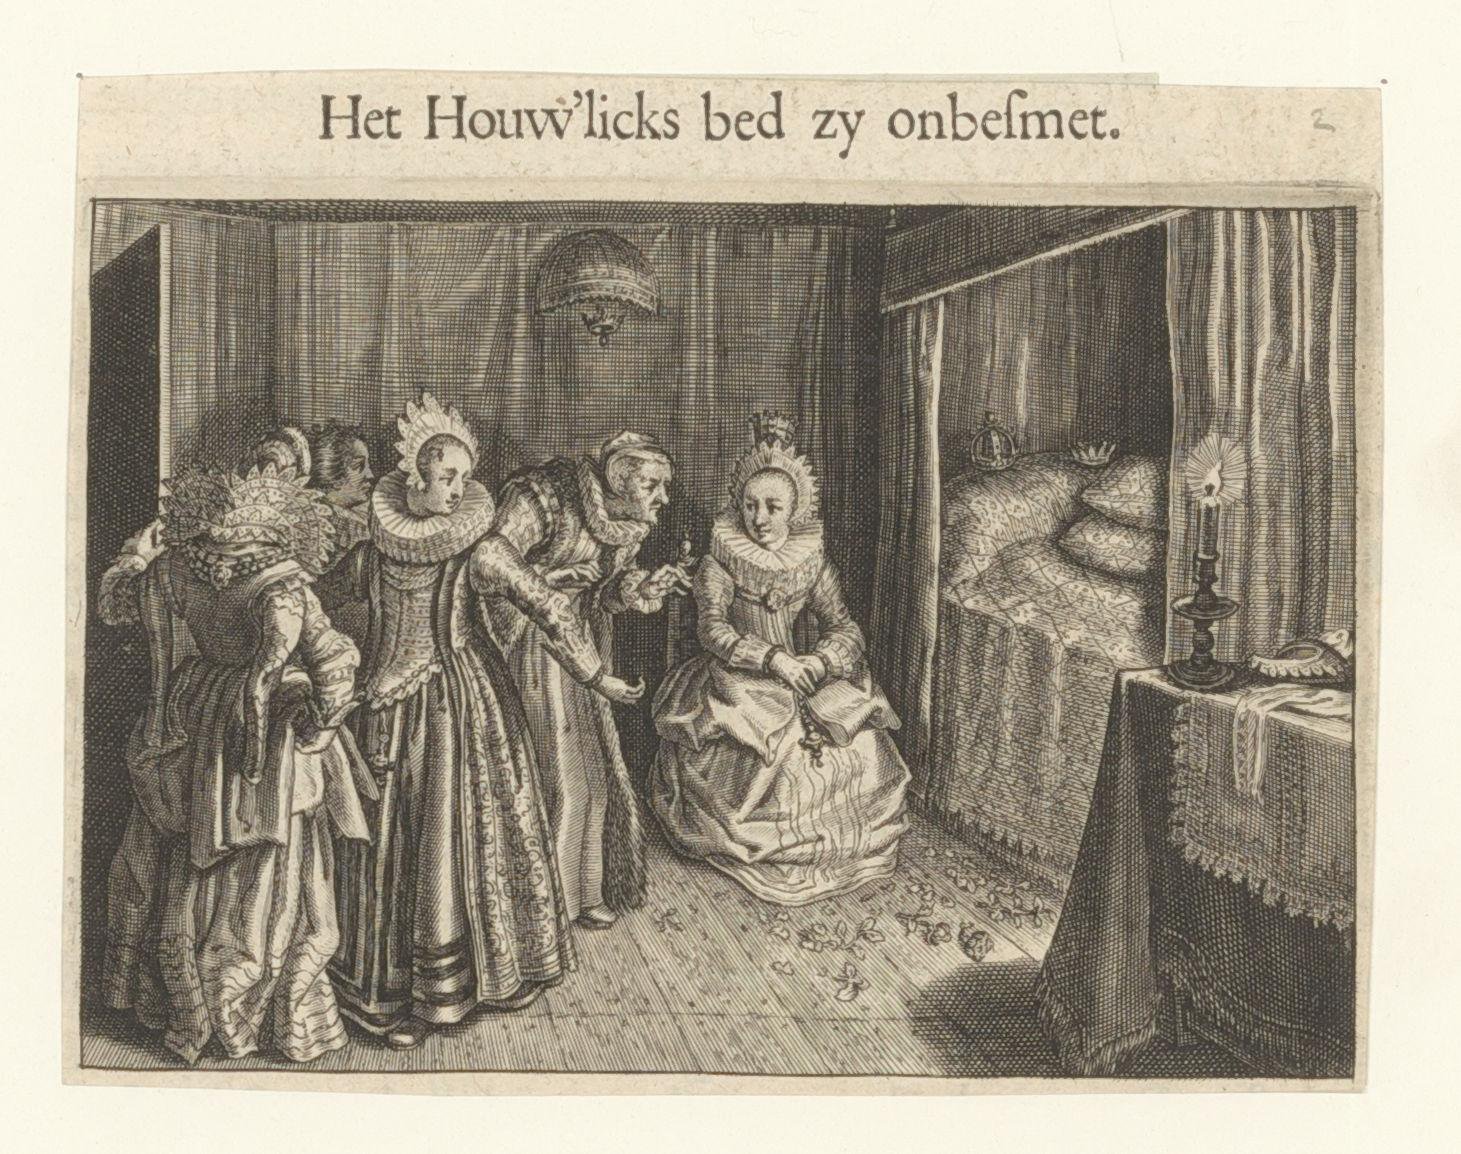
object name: print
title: Het Houw'licks bed zy onbesmet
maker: Anonymous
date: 1624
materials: paper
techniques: engraving, letterpress printing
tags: flowers, adolescent, young woman, maiden, chastity, bed with tester, old woman, proverbs, sayings, etc., bedroom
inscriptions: collector's mark: Lugt 1641, stamp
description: Tweede embleem uit: Brune, Johan de. Zinne-werck, Voor-ghesyelt in Beelden, Ghedichten, ende breeder uyt-legginghen (...). Amsterdam: Evertsen Kloppenburch, 1624. Prent ook gebruikt in latere edities (1636 en 1661).